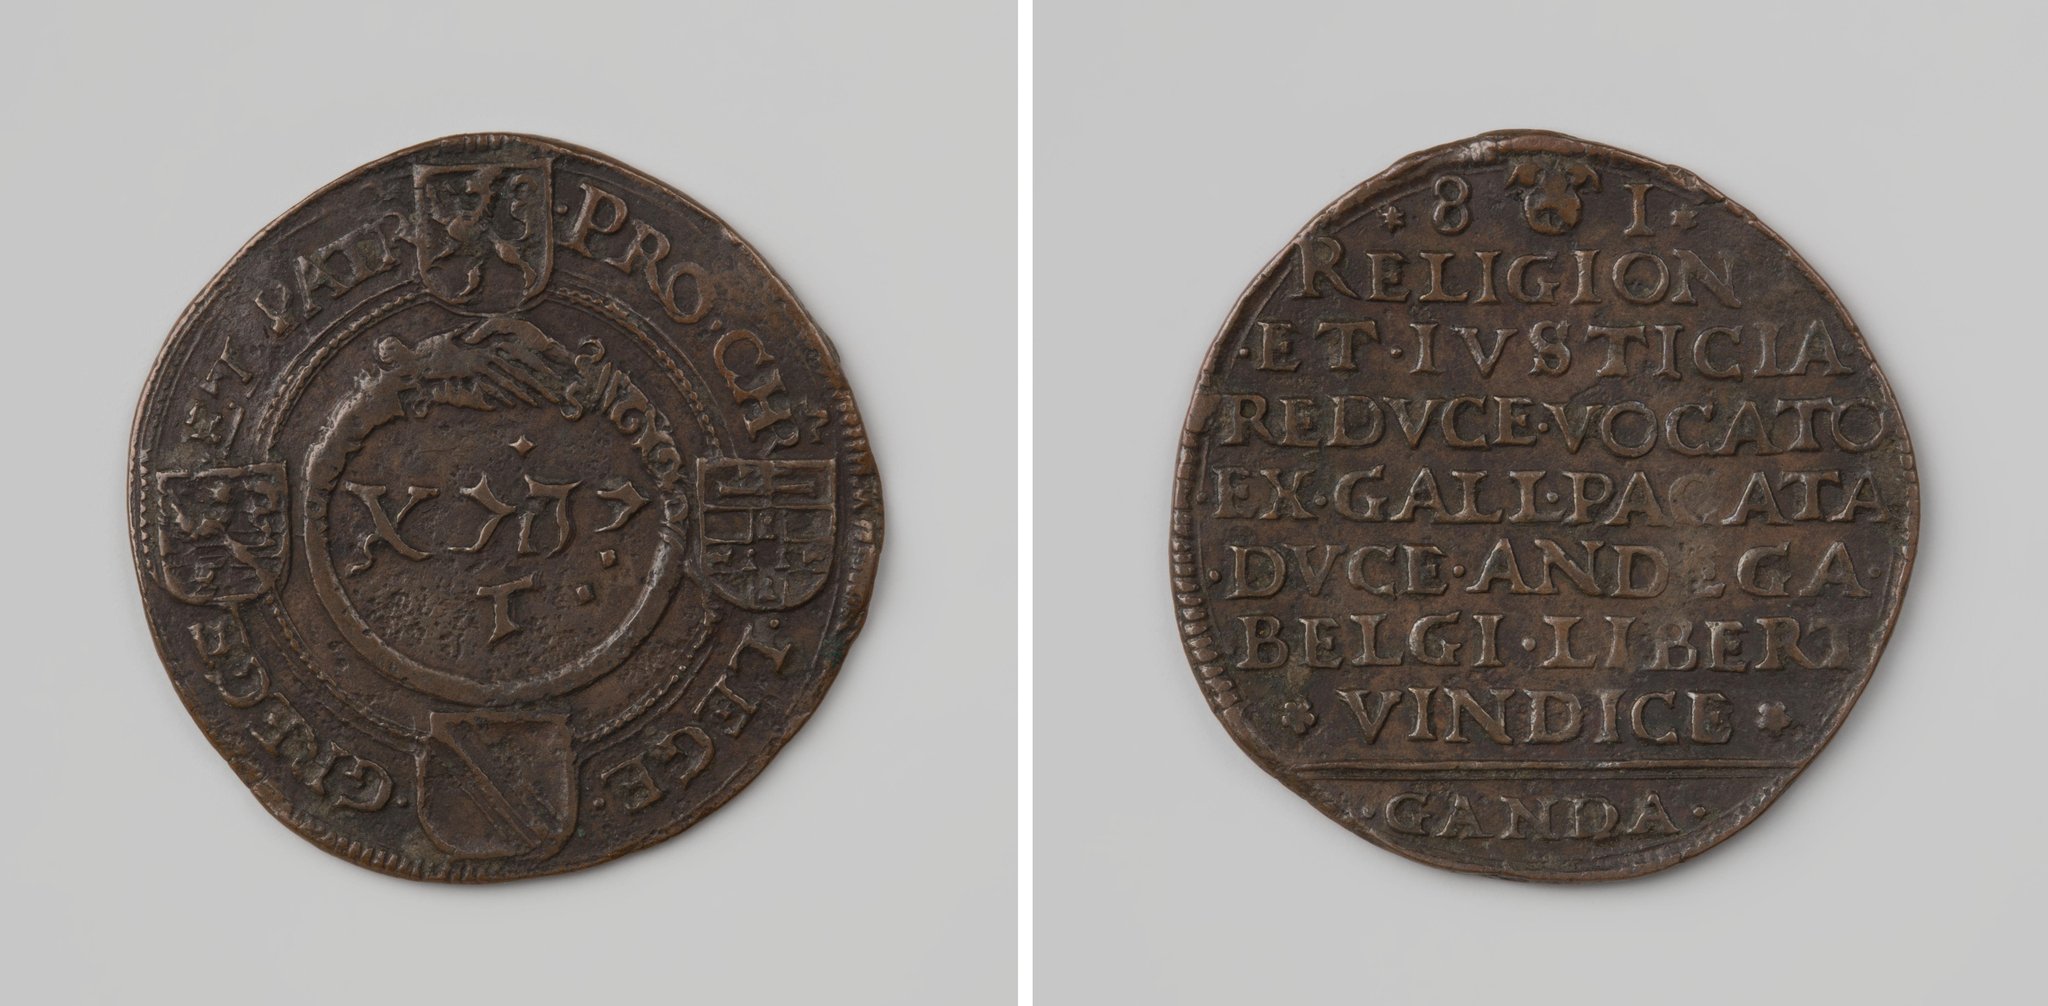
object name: jeton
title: Francois-Hercule, hertog van Anjou door de Vier Leden van Vlaanderen als landsheer aanvaard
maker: Anonymous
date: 1581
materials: copper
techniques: striking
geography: ghent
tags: paris, françois-hercule de valois (hertog van anjou)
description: Koperen penning. Voorzijde: naam Jehovah in Hebreeuws schrift binnen cirkel, die aan bovenzijde eindigt in twee ineen geslagen handen binnen omschrift, onderbroken door vier wapenschilden. Keerzijde: opschrift